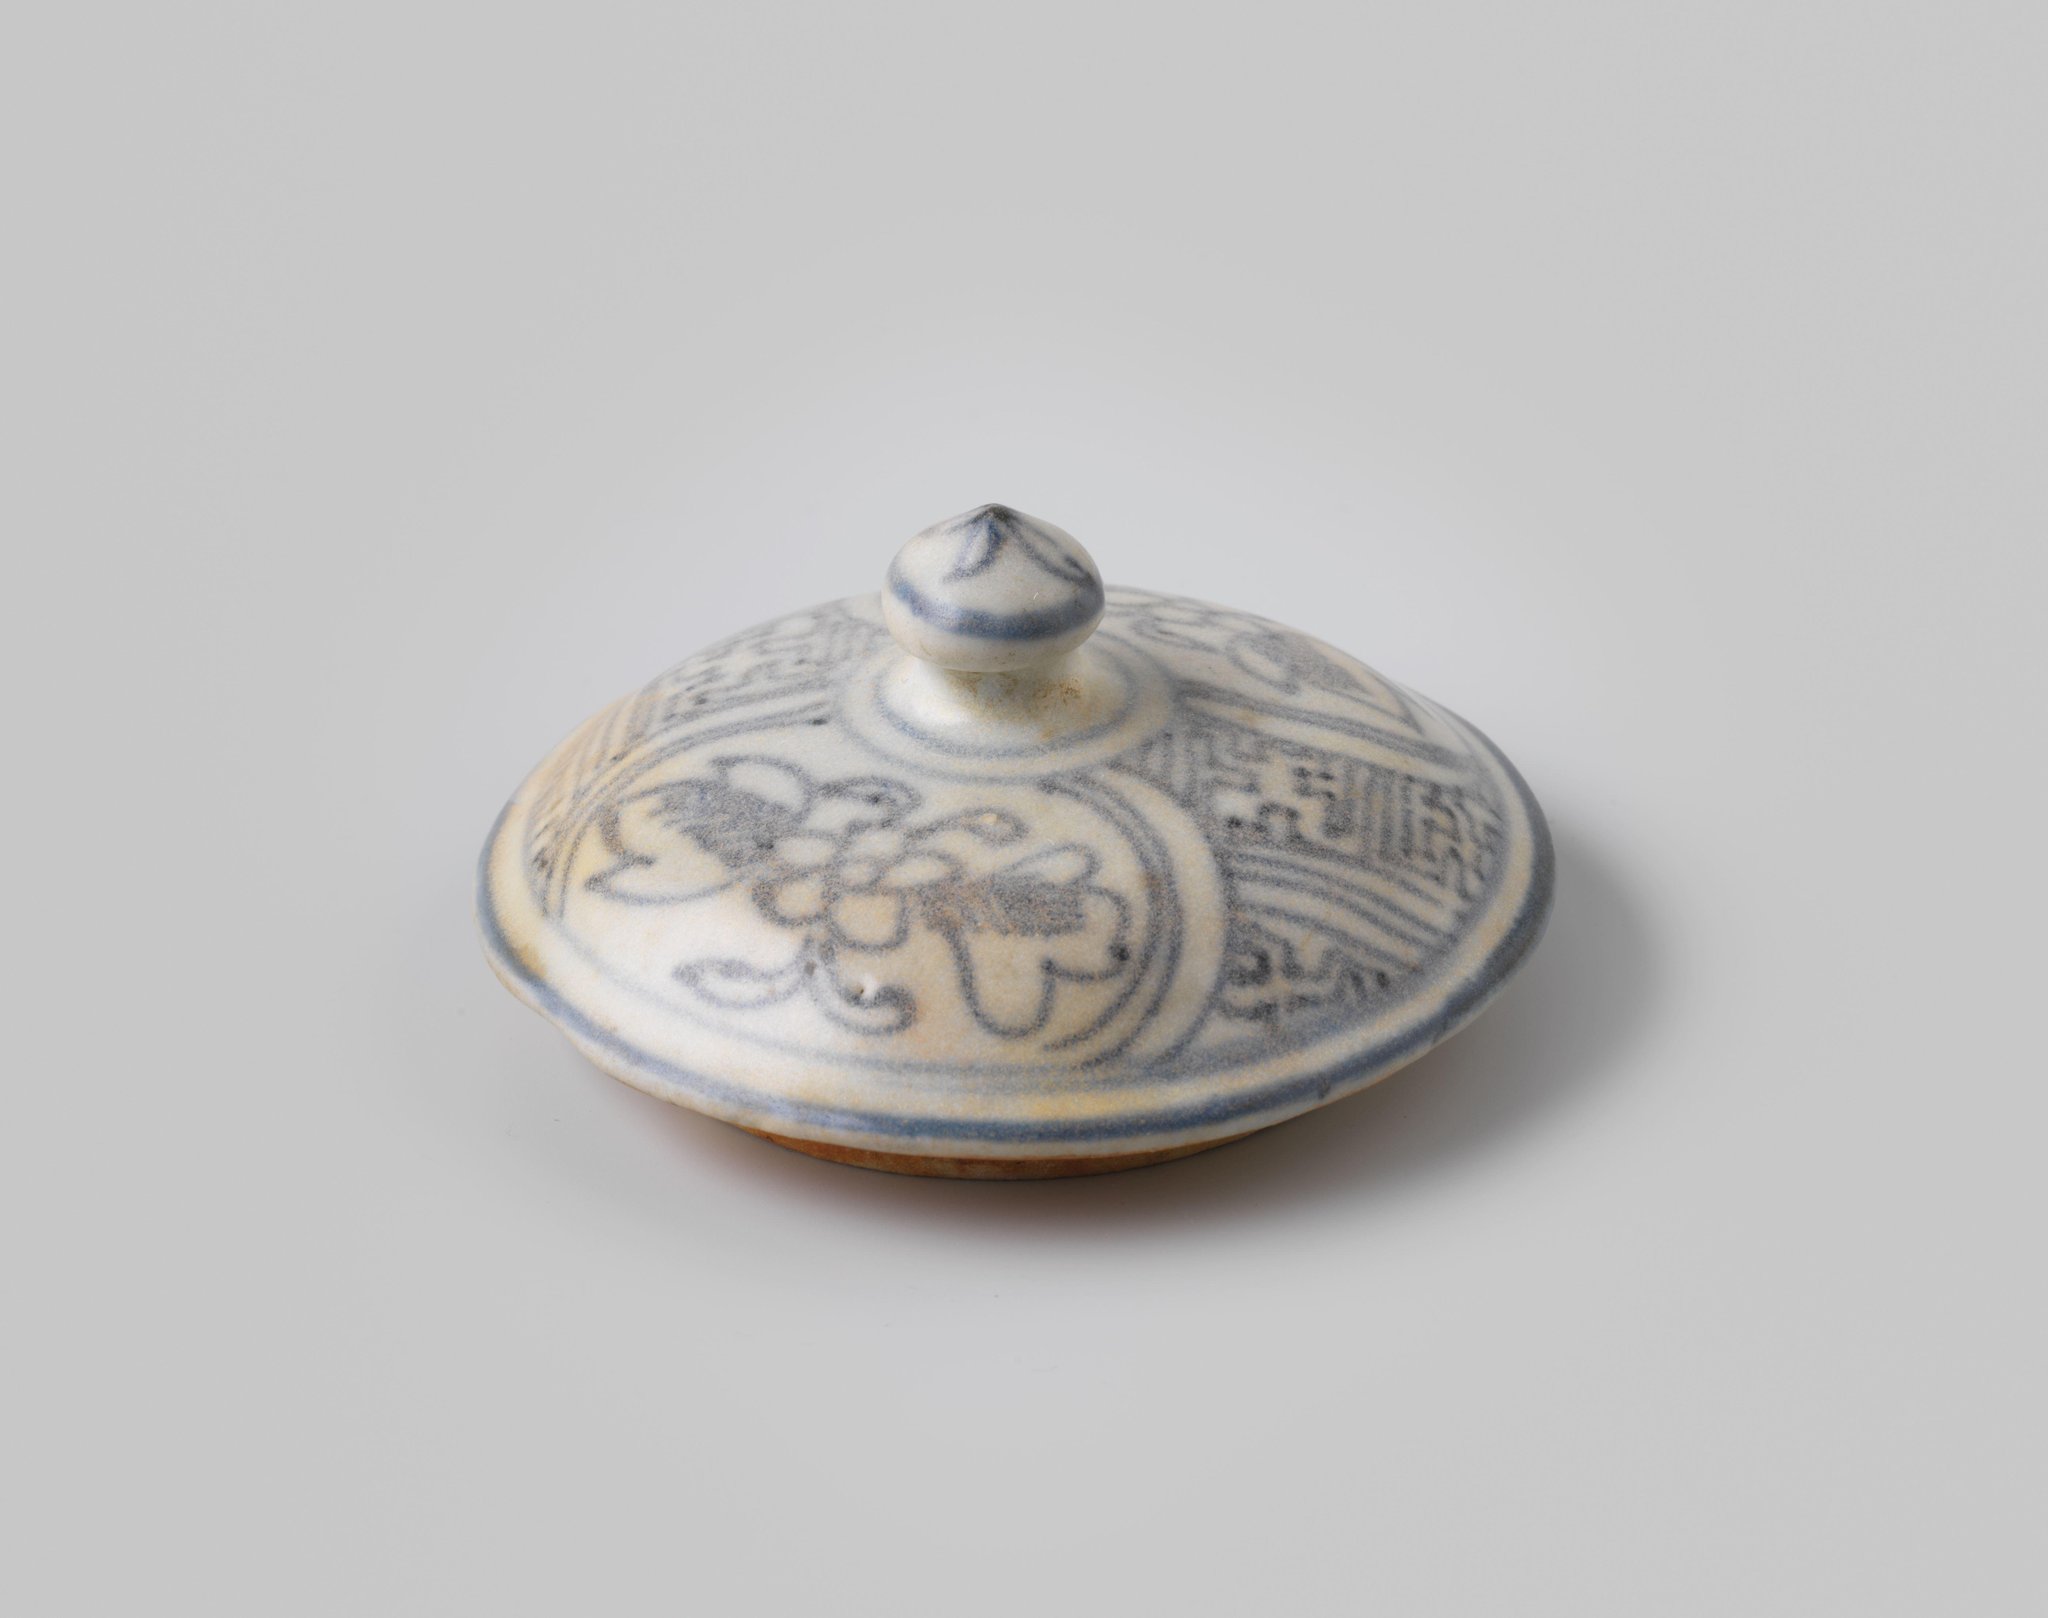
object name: lid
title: Lid of a winepot of Chinese porcelain from the wreck of the Dutch East Indiaman Witte Leeuw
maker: Anonymous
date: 1613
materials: bone china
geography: jingdezhen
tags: verenigde oostindische compagnie, sint-helena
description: Winepot with a handle and spout. The panels decorated with peonies and symbols. Shoulder and cover are decorated with two cartouches with floral sprays on a fine diaper pattern. The handle is decorated with various motives: dots and flower sprays. The spout with flame motives and stylized jewels and the cover with floral sprays and cartouches on diaper pattern. The neck with two sketchy flower sprays.